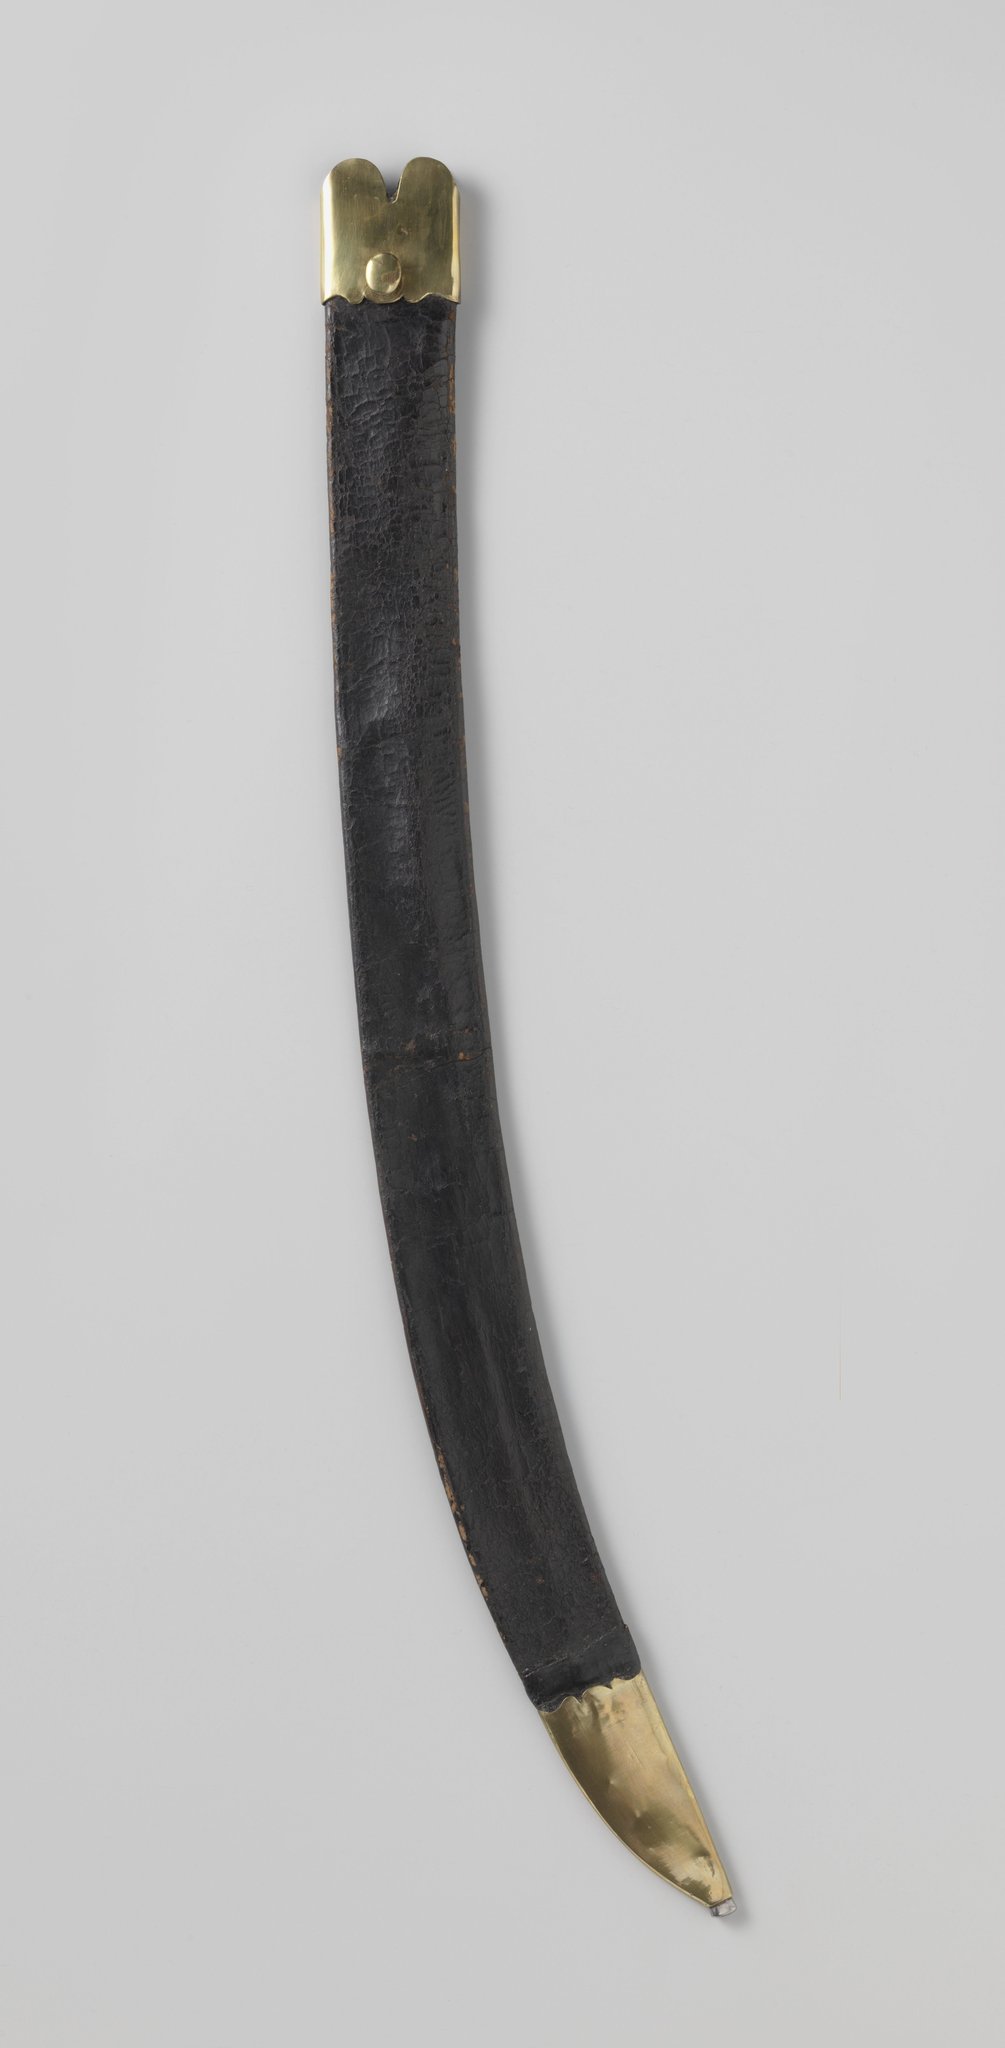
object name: knife with sheath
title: Schede van Algerijnse sabel van Cornelis Tromp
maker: Anonymous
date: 1600-1700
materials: brass, leather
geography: algeria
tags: rotterdam, amsterdam, cornelis tromp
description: Sabel met schede van Cornelis Tromp. Perzisch of Indisch archipel. Houten greep, met gegraveerde zilveren platen bekleed. Koperen montuur, min of meer in de vorm van een beulenkop, waarin aan de ene zijde een glazen plaatje als een oog.